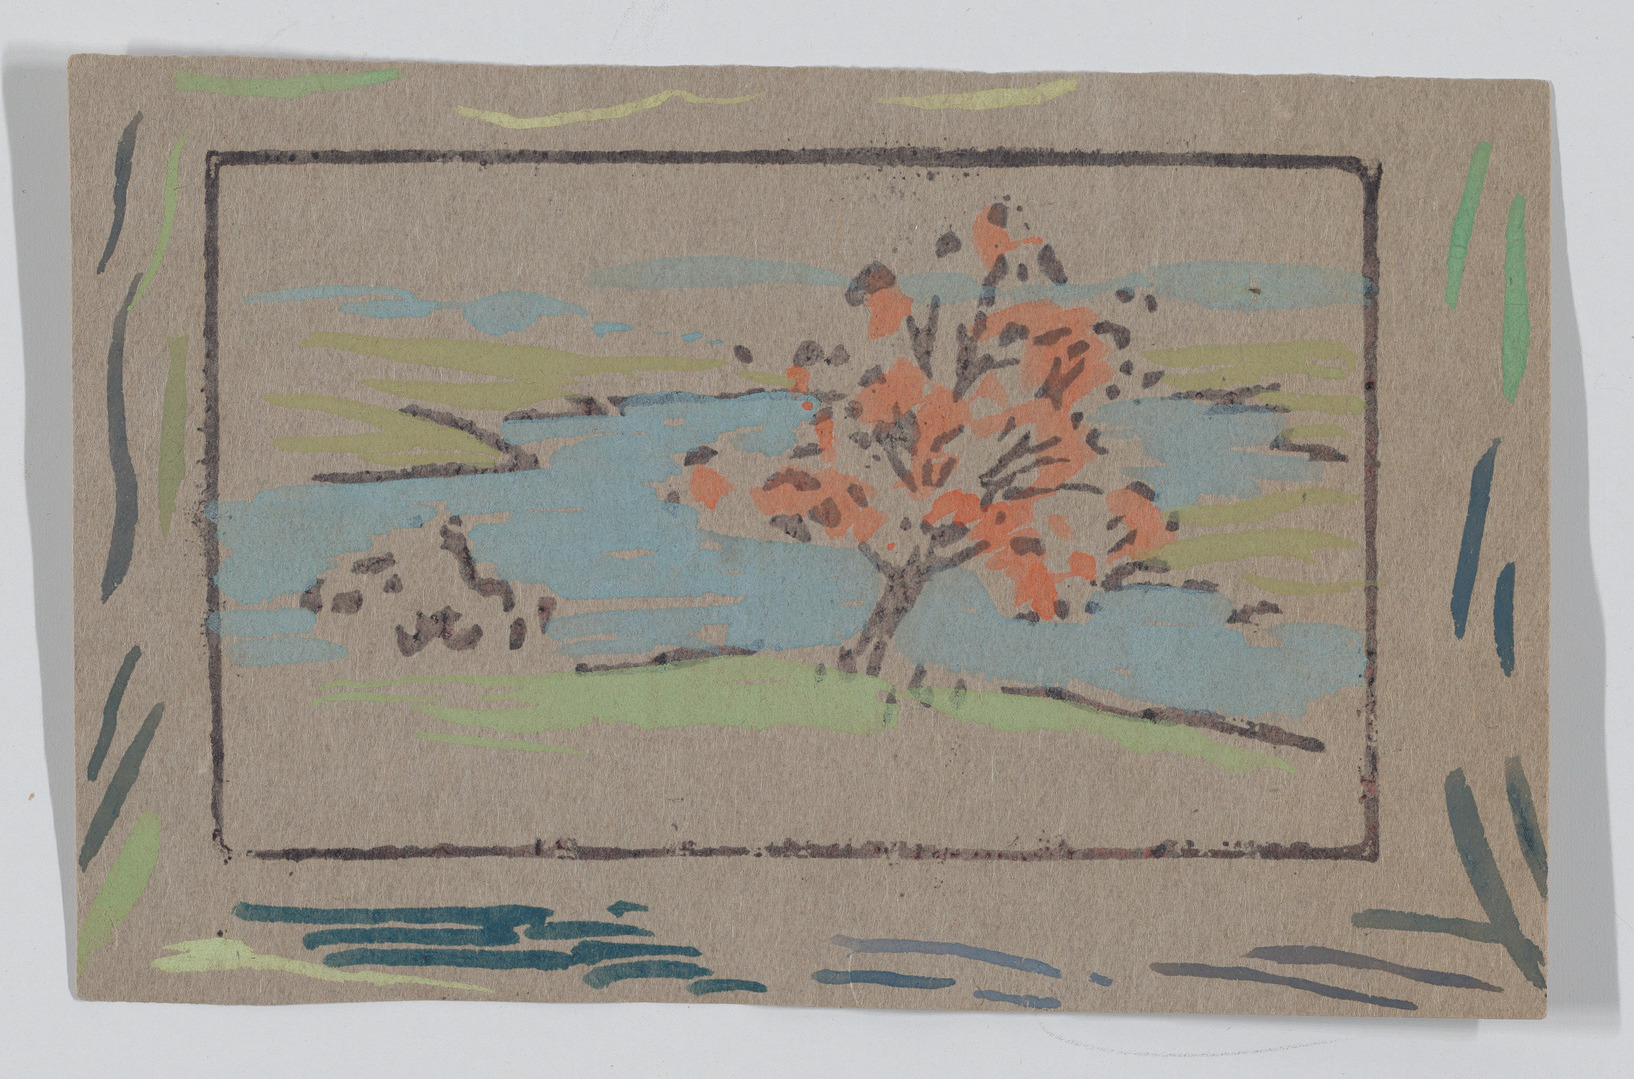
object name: woodcut, print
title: Nabby's Point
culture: american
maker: arthur wesley dow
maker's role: artist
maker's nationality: american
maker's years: 1857-1922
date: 1913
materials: gouache, paper, watercolor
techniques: woodcut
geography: united states